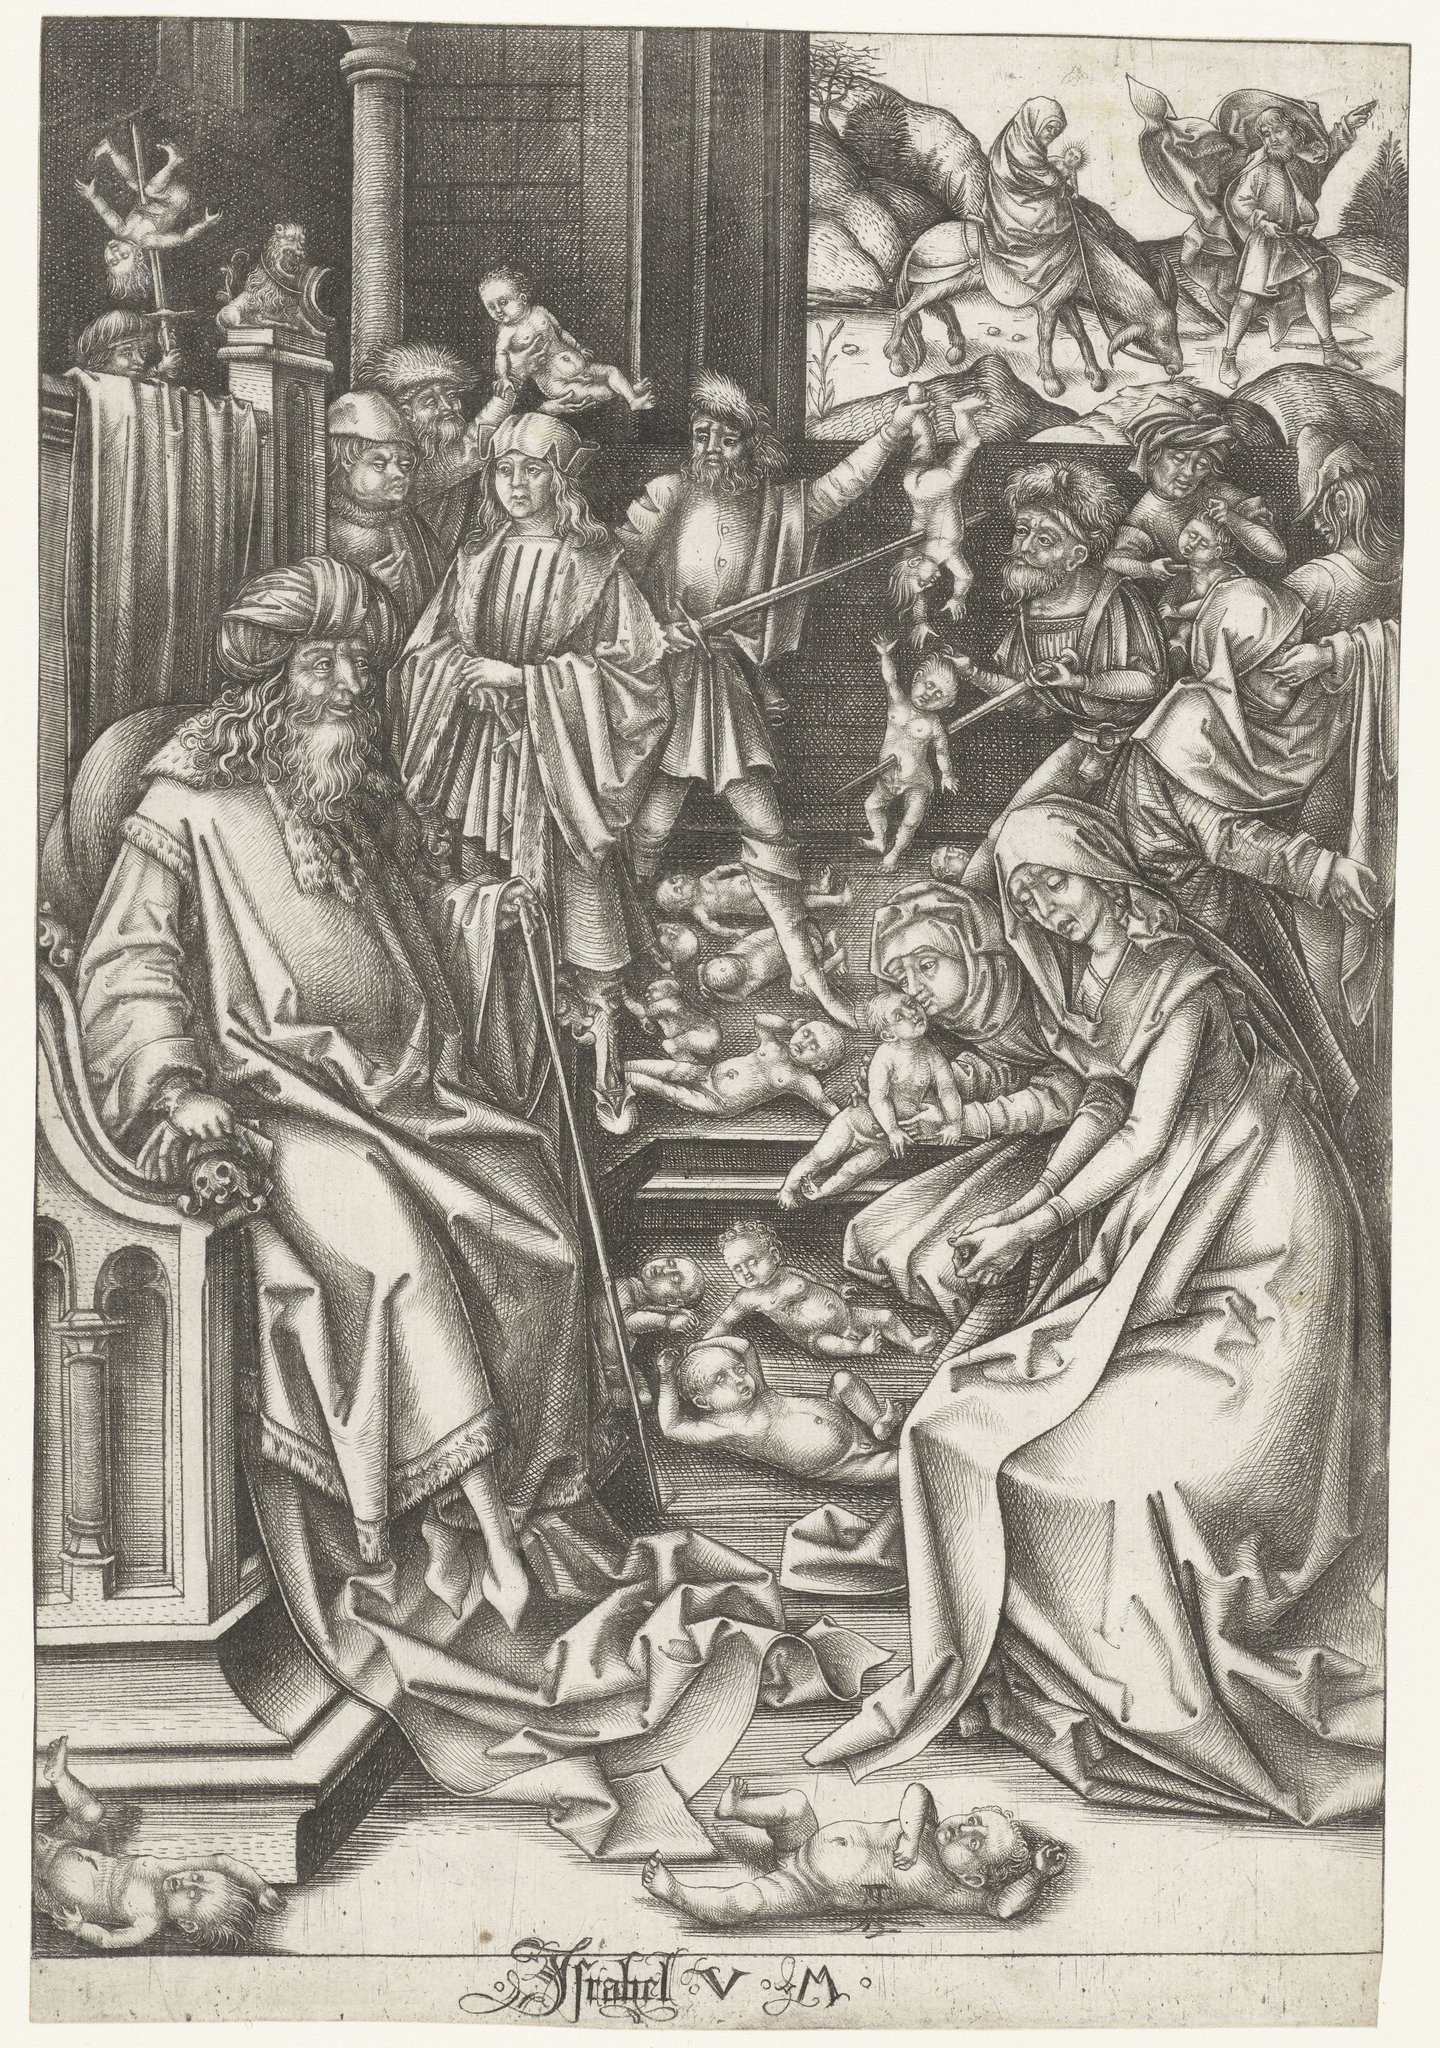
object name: print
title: Het leven van Maria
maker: israhel van meckenem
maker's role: print maker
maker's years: 1440-1517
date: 1455-1503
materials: paper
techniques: engraving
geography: bocholt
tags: the flight into egypt: mary, joseph, the child (and sometimes others) on their way; mary usually riding on an ass, the massacre ot the innocents; sometimes herod looking on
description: Herodes zit op een troon, terwijl om hem heen vele kleine jongetjes worden vermoord door soldaten. Een vrouw smeekt Herodes om genade. Op de achtergrond is te zien hoe Jozef en Maria met het Christuskind naar Egypte vluchten. Deze prent is onderdeel van een serie van twaalf prenten met scènes uit het leven van Maria.